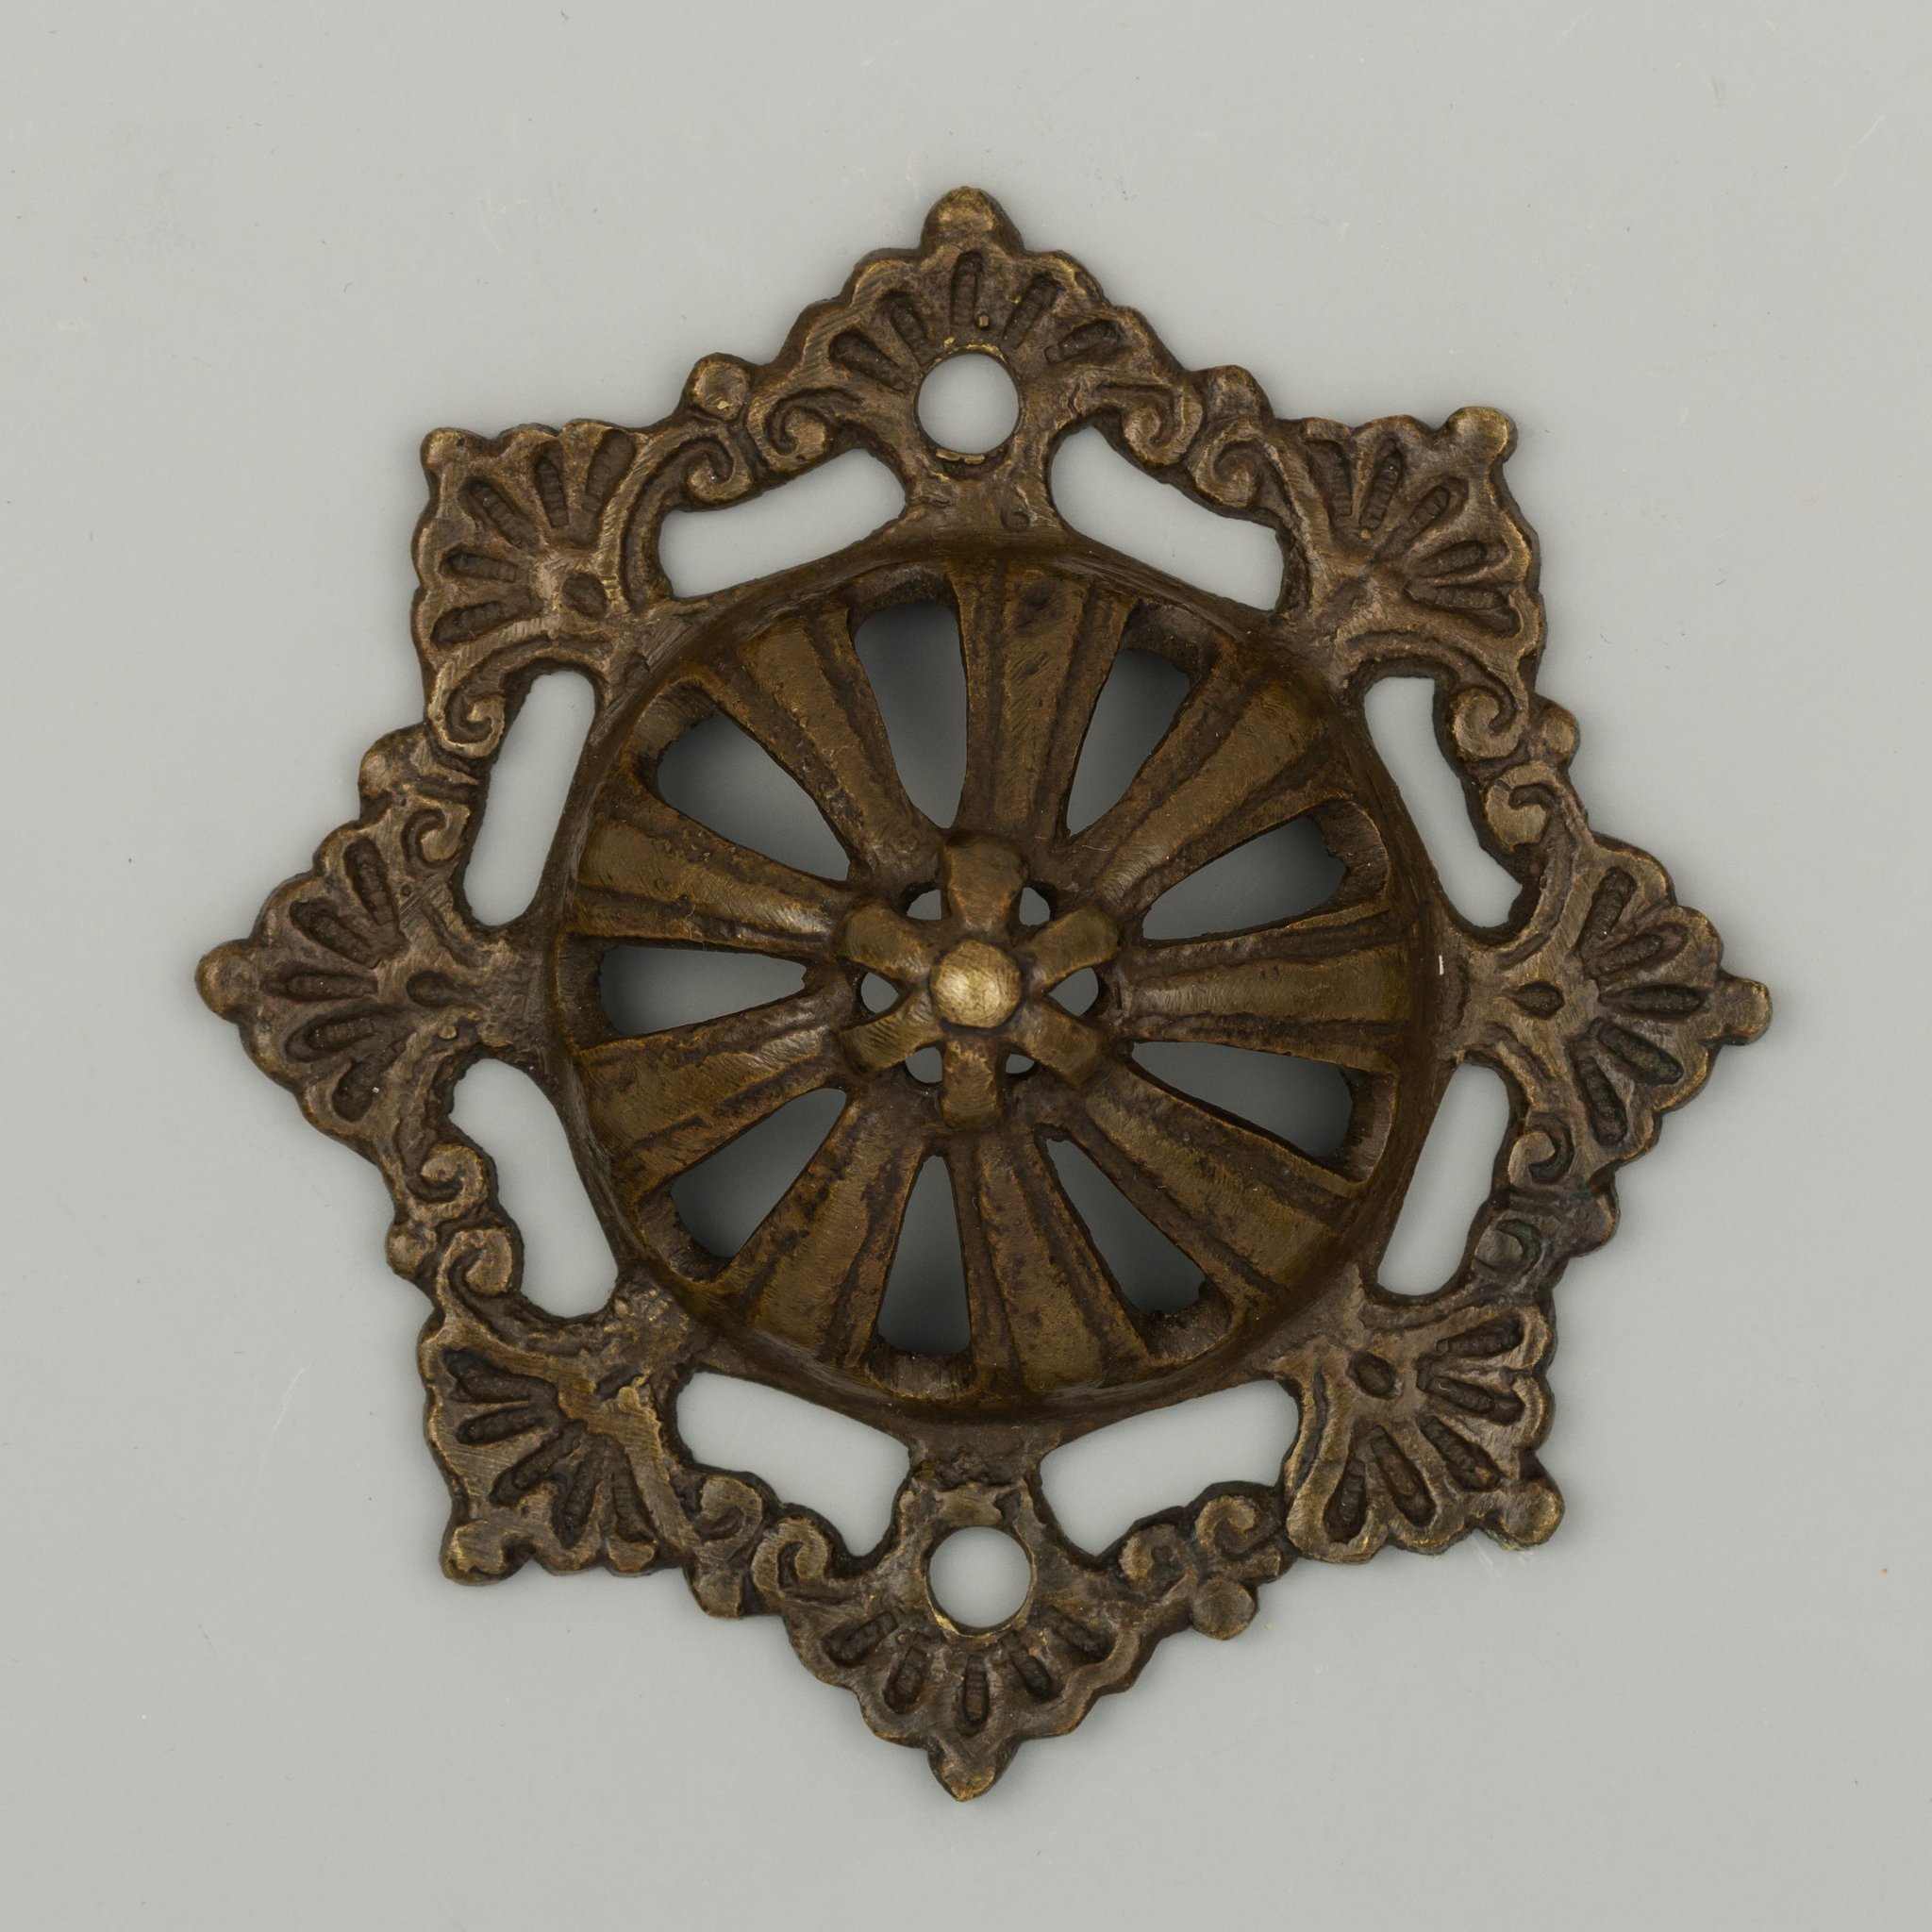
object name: bit bos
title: Bit Boss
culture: dutch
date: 1601-1650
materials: copper alloy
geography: netherlands